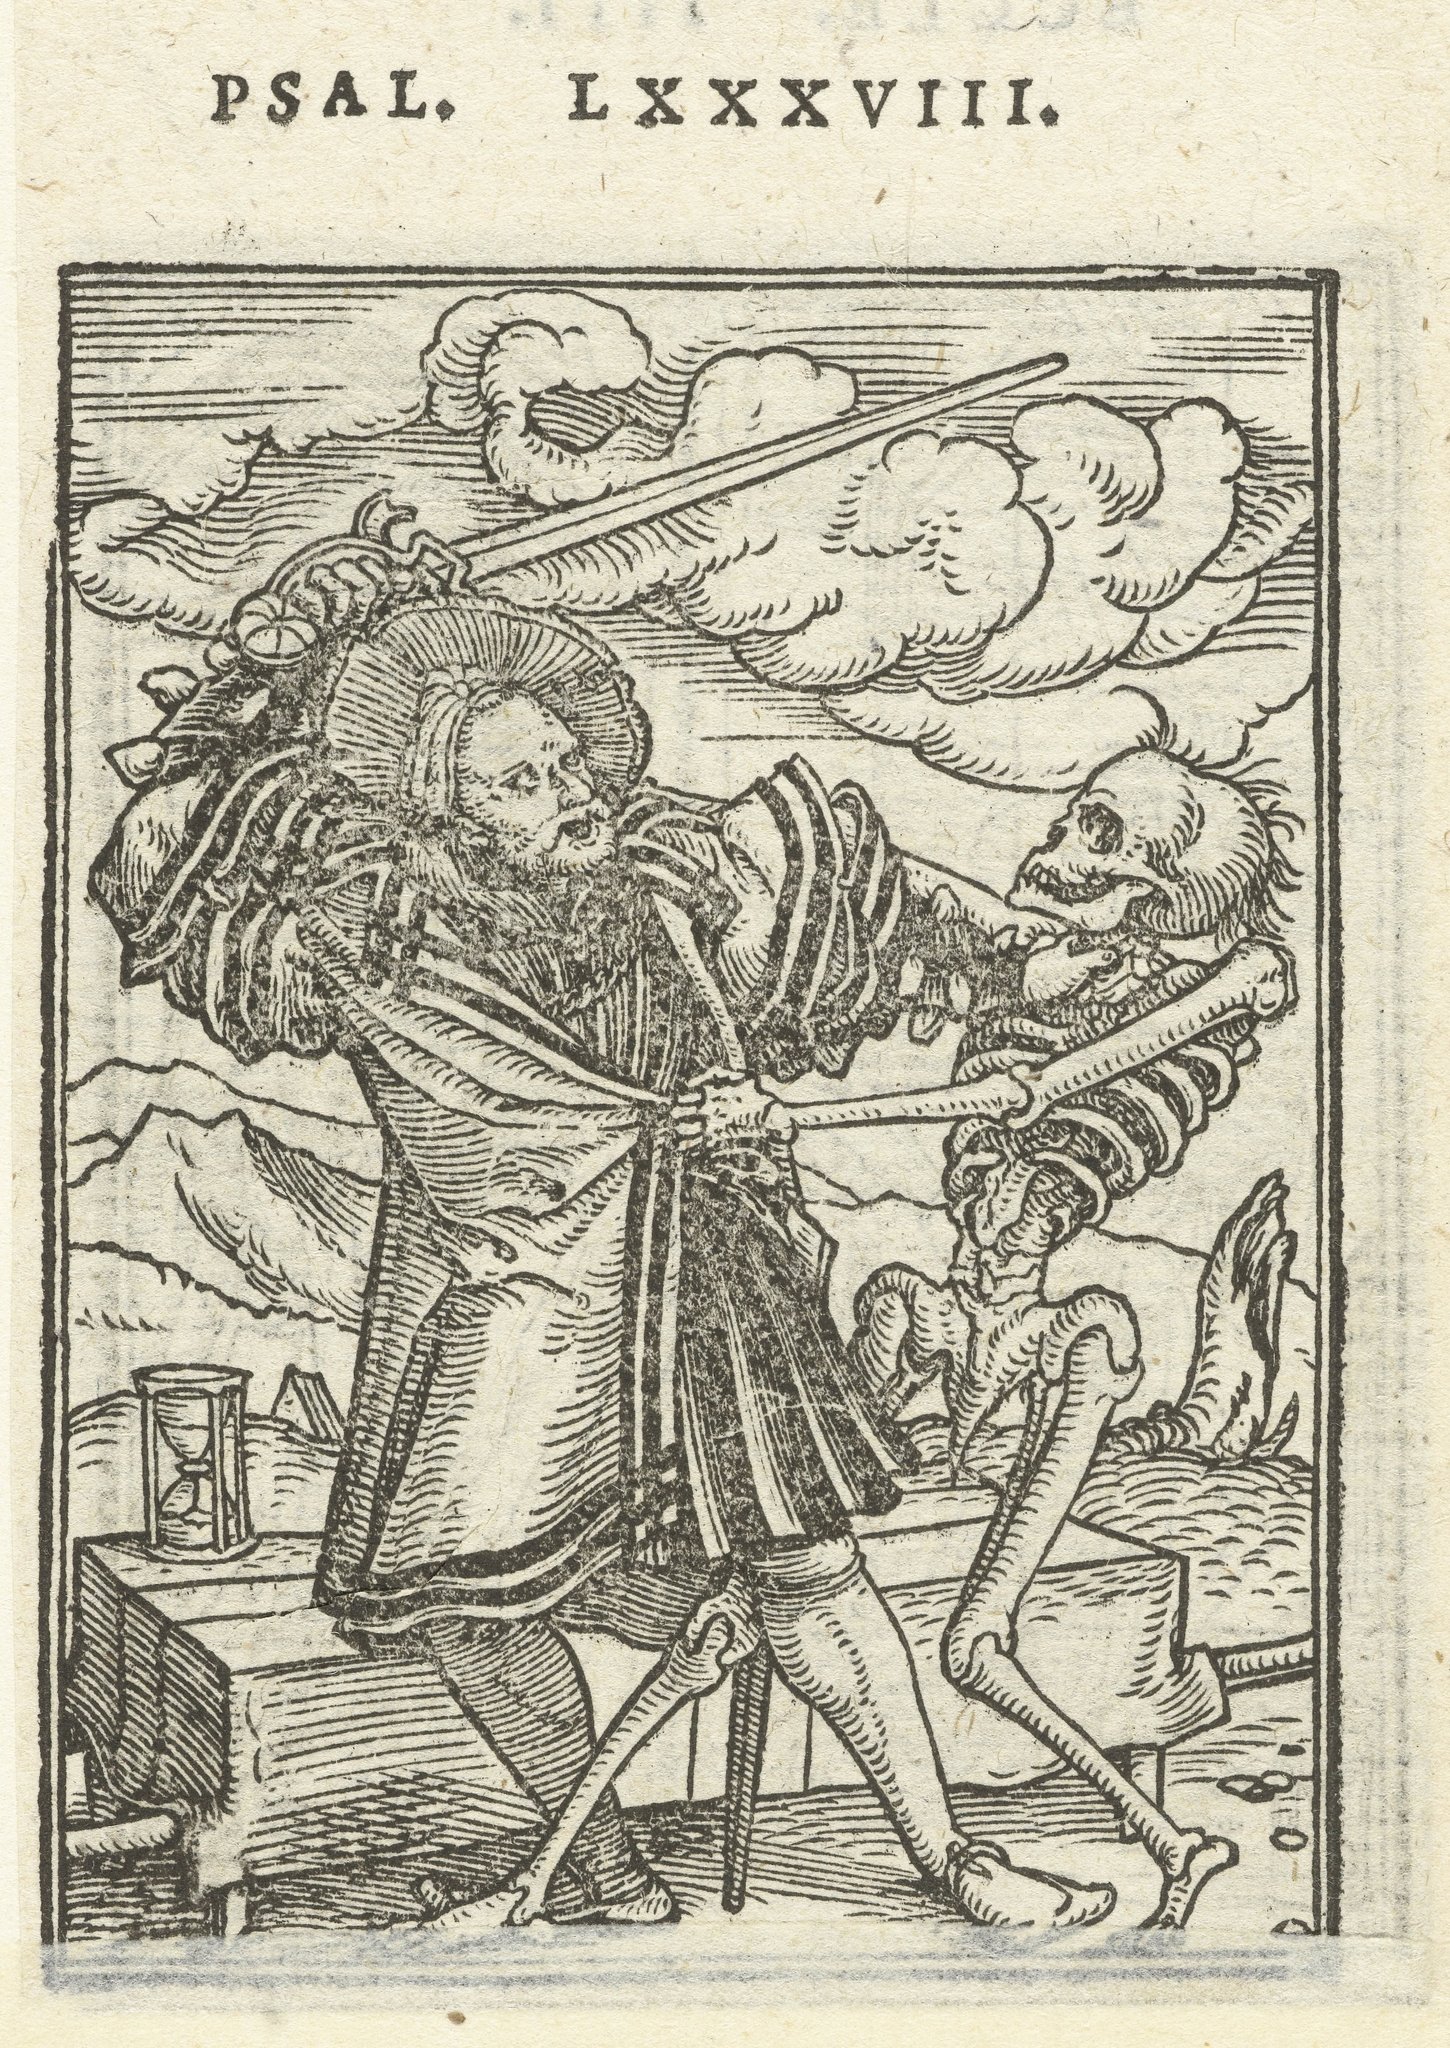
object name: print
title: Dodendans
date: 1524-1526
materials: paper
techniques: woodcut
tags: dance of death; death together with one or more human beings, nobility and patriciate; chivalry, knighthood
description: De houtblokken werden voor 1526 vervaardigd door Hans Lützelburg en pas in 1538 voor het eerst gebruikt als boekillustraties in: Les simulachres & historiees faces de la mort avtant elegamment pourtraictes que artificiellement imaginées... a Lyon, Soubsz l'escu de Coloigne, MDXXXVIII, (M. en G. Trechsel, voor F. Frellon in Lyon), 1538. Later verschenen nog andere uitgaven.